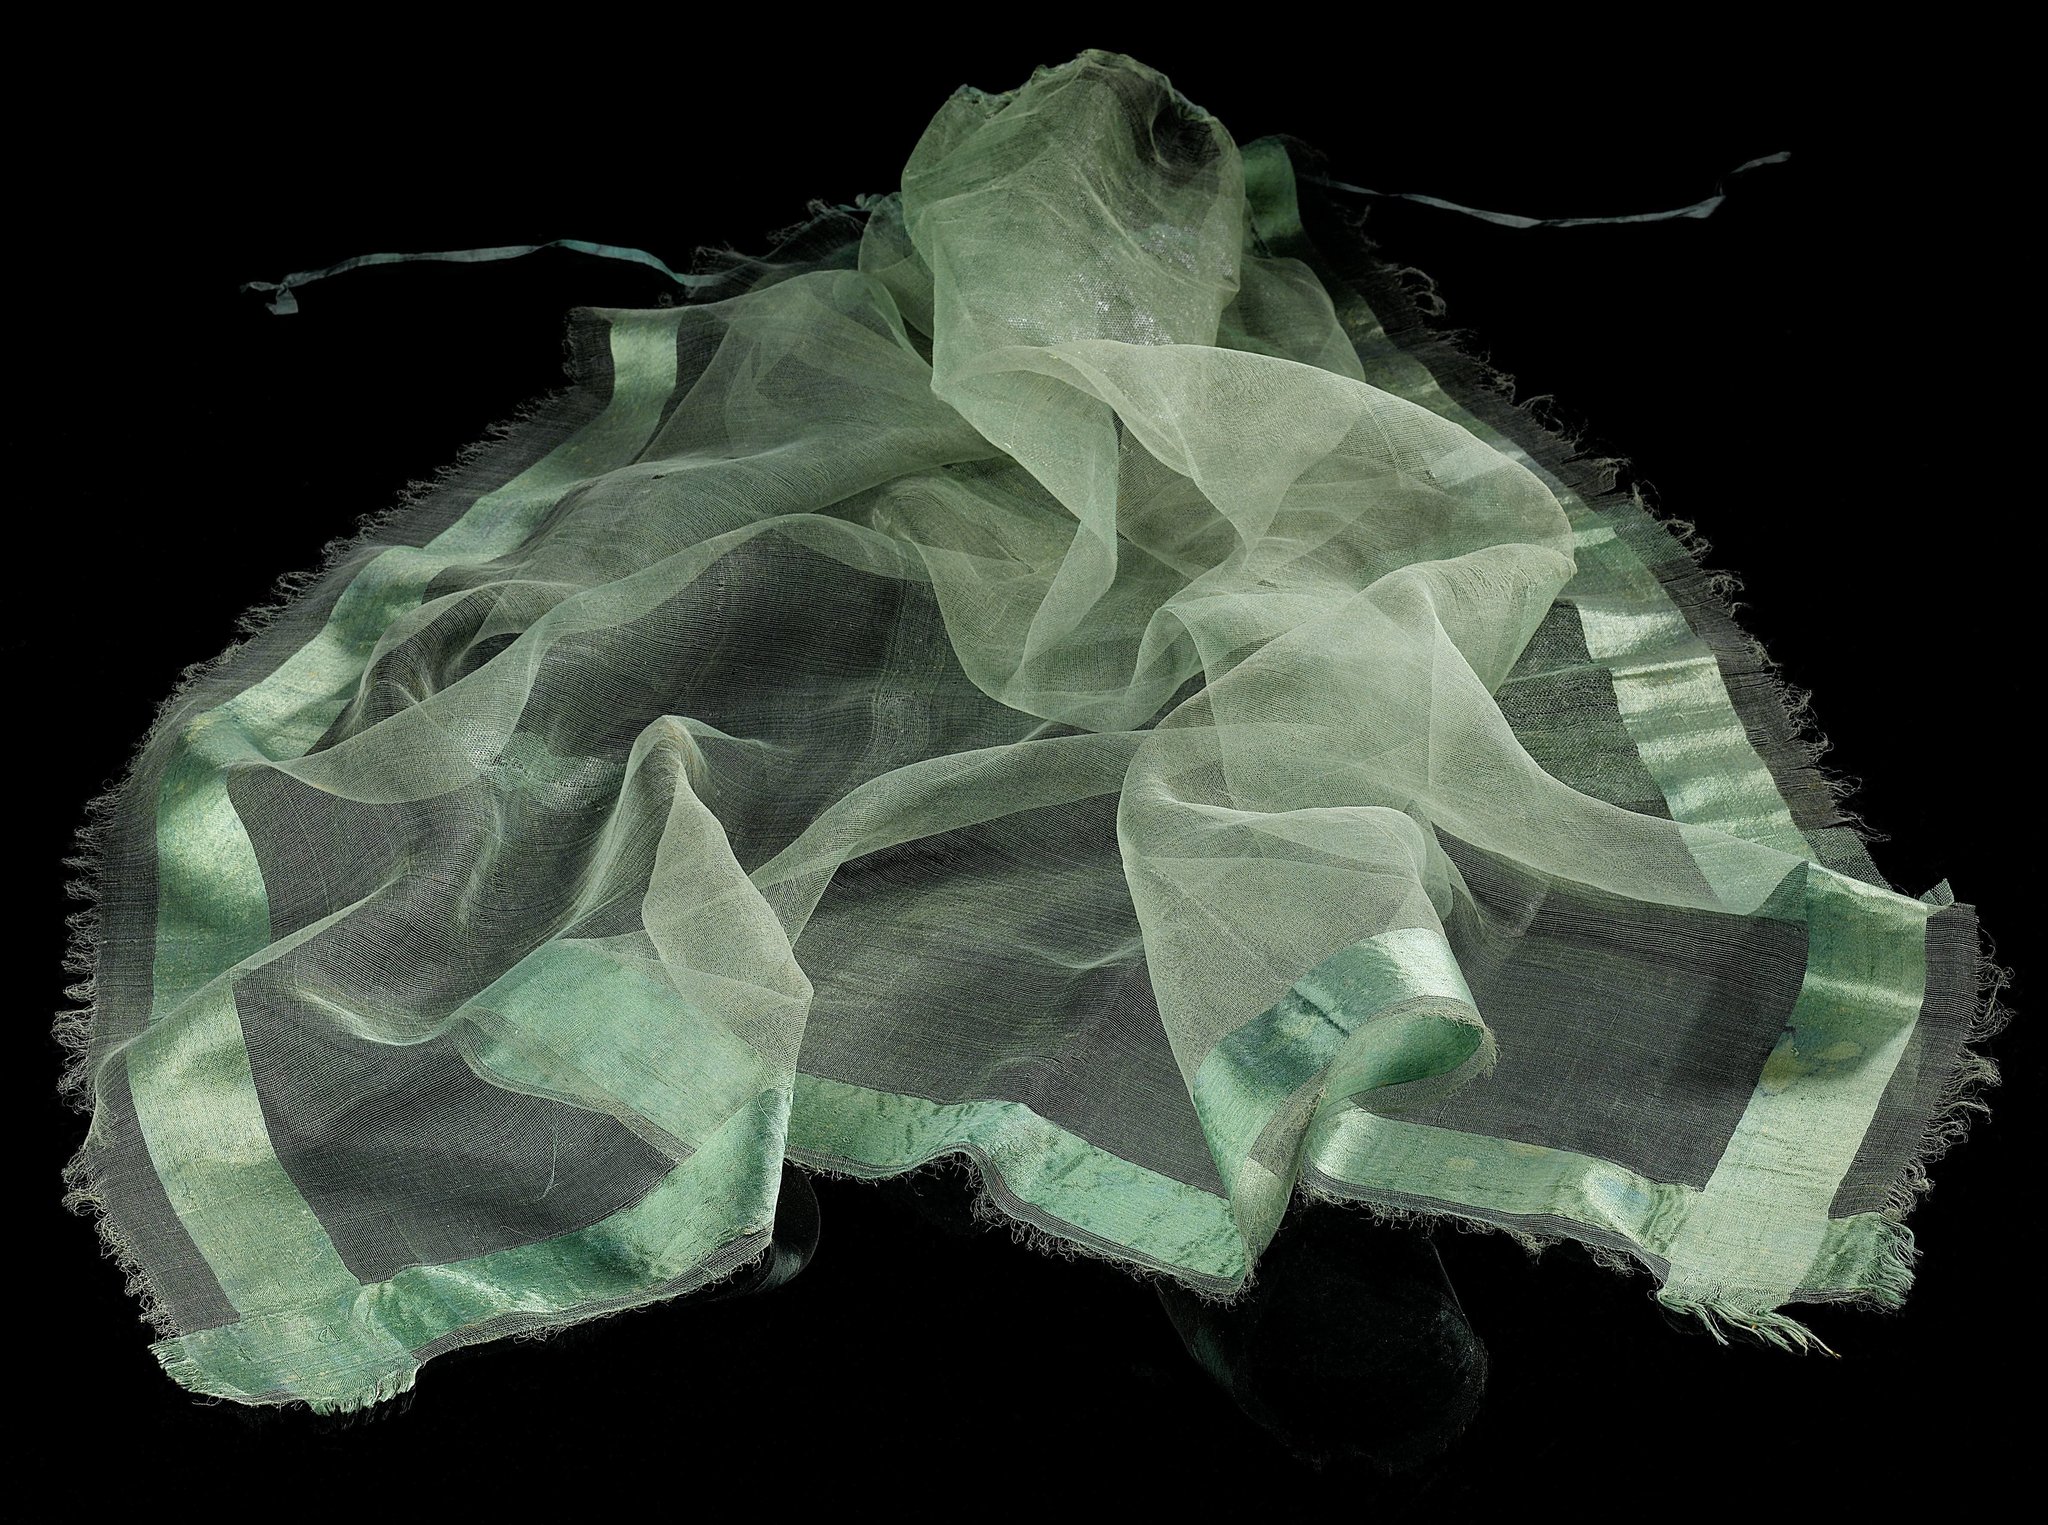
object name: veil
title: Voile van groene gaze de soie aan drie kanten voorzien van een ingeweven satijnen rand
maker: Anonymous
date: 1820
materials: silk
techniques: weave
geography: france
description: Hoedenvoile van groene gaze de soie. De versiering bestaat uit een aan drie kanten ingeweven brede satijnen band en uit een gerafelde franjerand. Aan de bovenzijde een sleufje met een groen bandje.